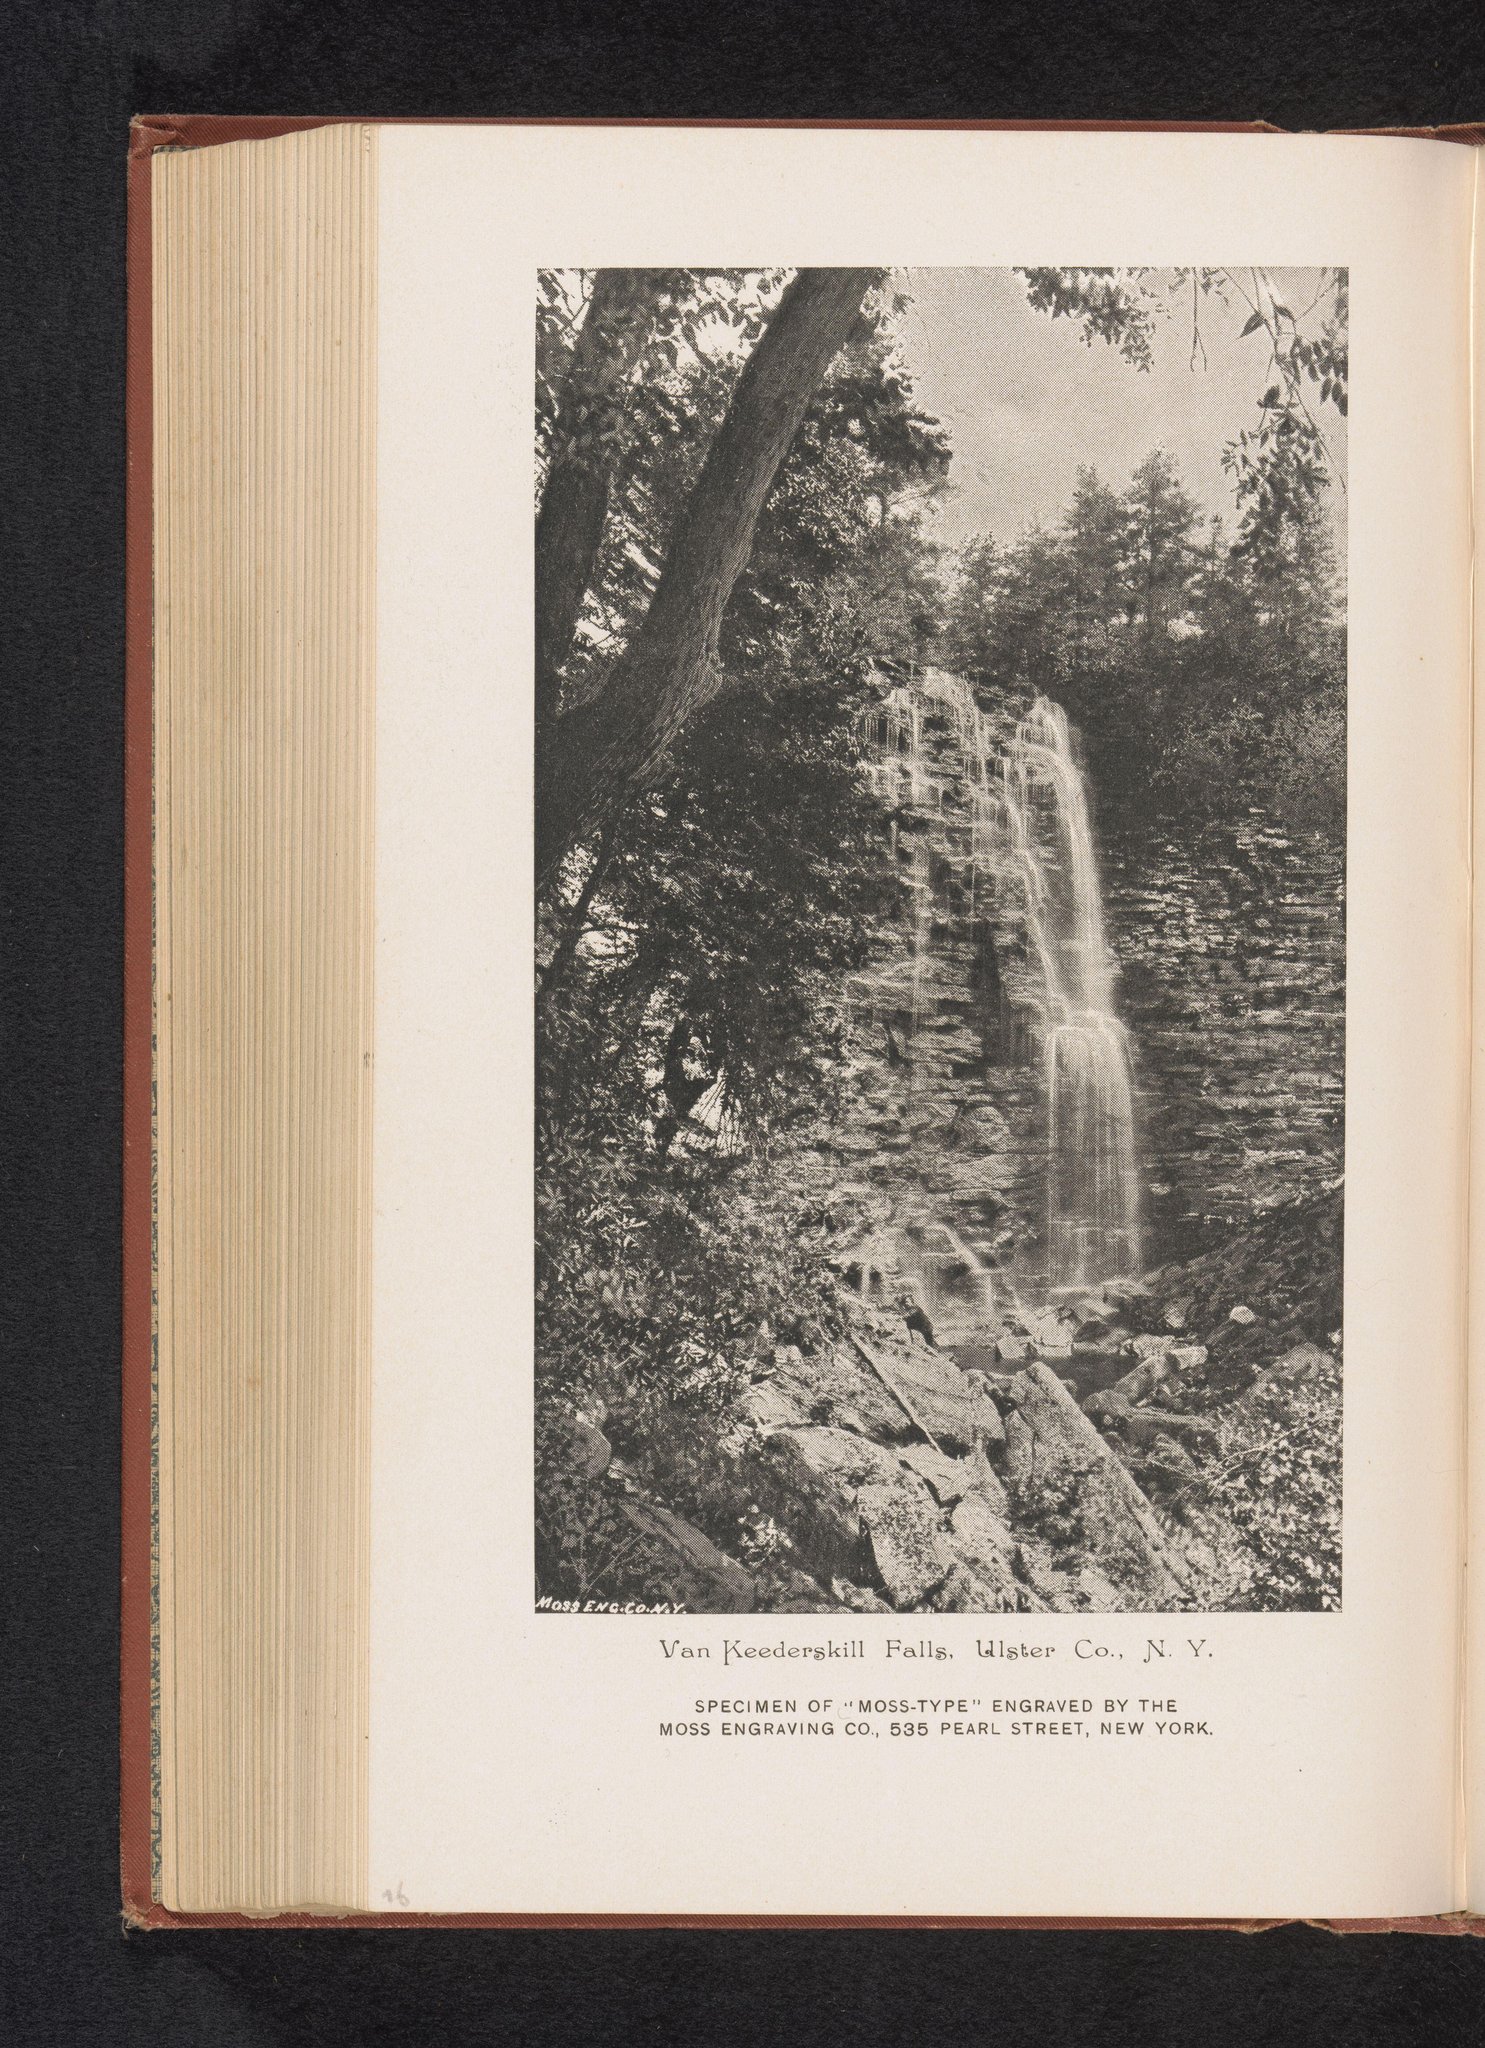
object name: page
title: Van Keederskill Falls, Ulster Co., N.Y.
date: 1884-1889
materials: paper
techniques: autotype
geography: kaaterskill falls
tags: waterfall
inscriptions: inscription: ‘Specimen of "Moss-Type" engraved by the/ Moss Engraving Co., 535 Pearl Street, New York.’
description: Prent op tweede ongenummerde pagina na pagina 328.